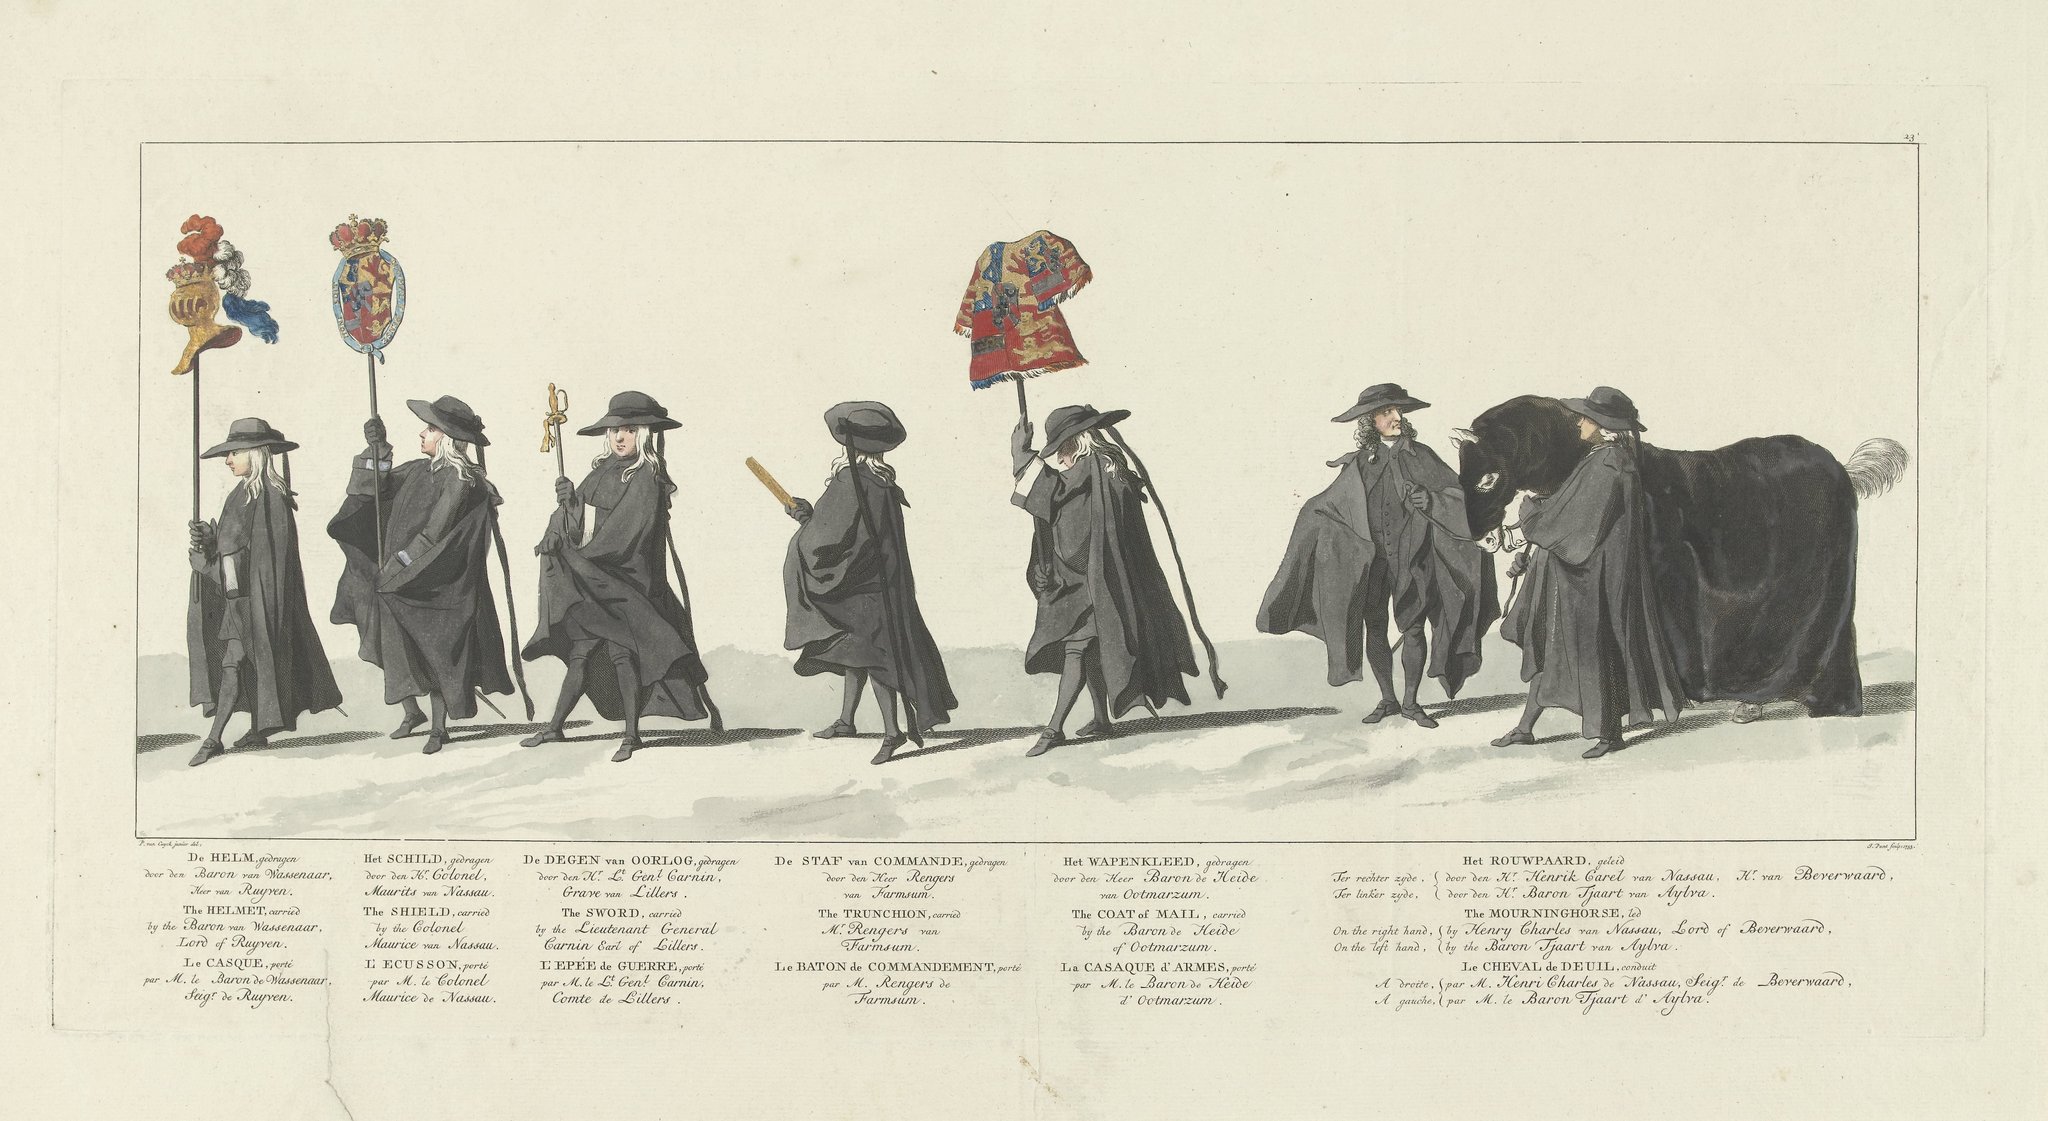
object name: print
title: Lyk-staetsie van zyne doorluchtigste Hoogheid den Heere Willem [IV] Carel Hendrik Friso, Prince van Orange en Nassau (...) gehouden den IV Februari 1752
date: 1753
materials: paper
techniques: engraving, etching, hand coloring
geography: northern netherlands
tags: the hague, willem iv (prins van oranje-nassau), cortege, funeral procession, insignia and symbols of sovereignty (crown, diadem, sceptre, orb, seal, standard, cloak, pectoral), delft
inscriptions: collector's mark: Lugt 2228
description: Dragers met stadhouderlijke insignia en een rouwpaard. In de marge het onderschrift in Nederlands, Frans en Engels. Onderdeel van een serie van 41 platen van de begrafenisstoet van stadhouder Willem IV te Delft op 4 februari 1752. Genummerd rechtsboven: 23.